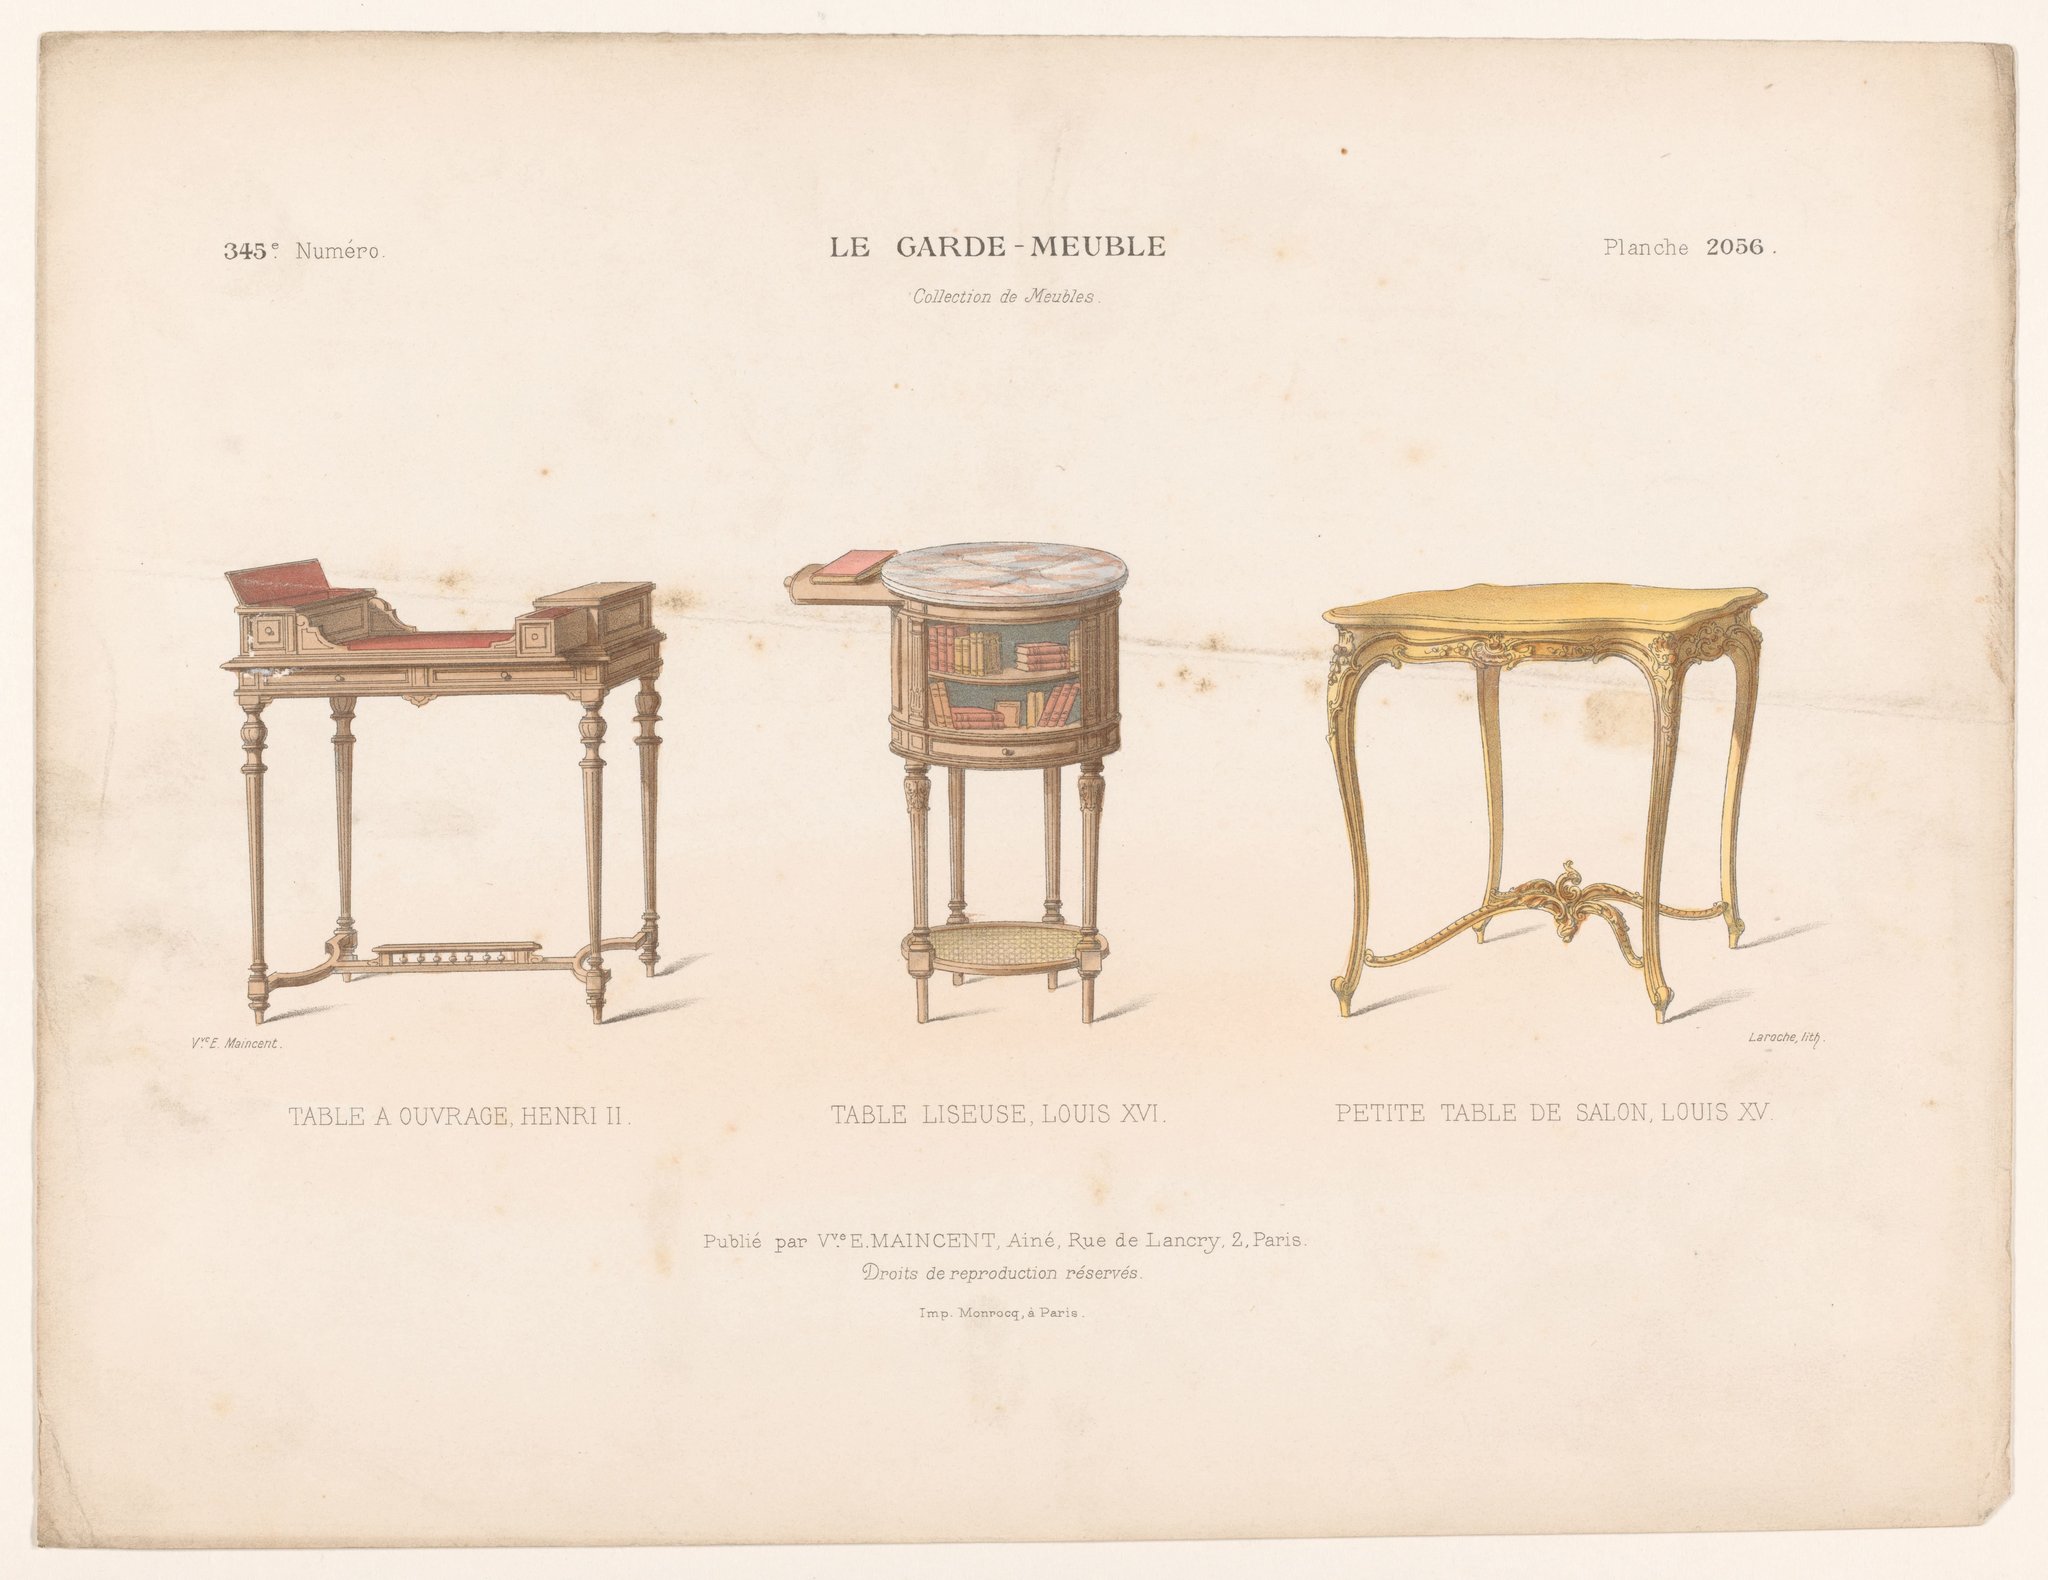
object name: print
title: Le garde-meuble / Collection de Meubles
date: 1895-1935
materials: paper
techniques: hand coloring, lithograph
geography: paris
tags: table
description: Ieder Livraison in de serie Le Garde-Meuble bevat negen platen: drie 'sièges' (zitmeubels), drie 'meubles' (diverse meubels zoals tafels en kasten) en drie 'tentures' (gordijnen en draperieën).